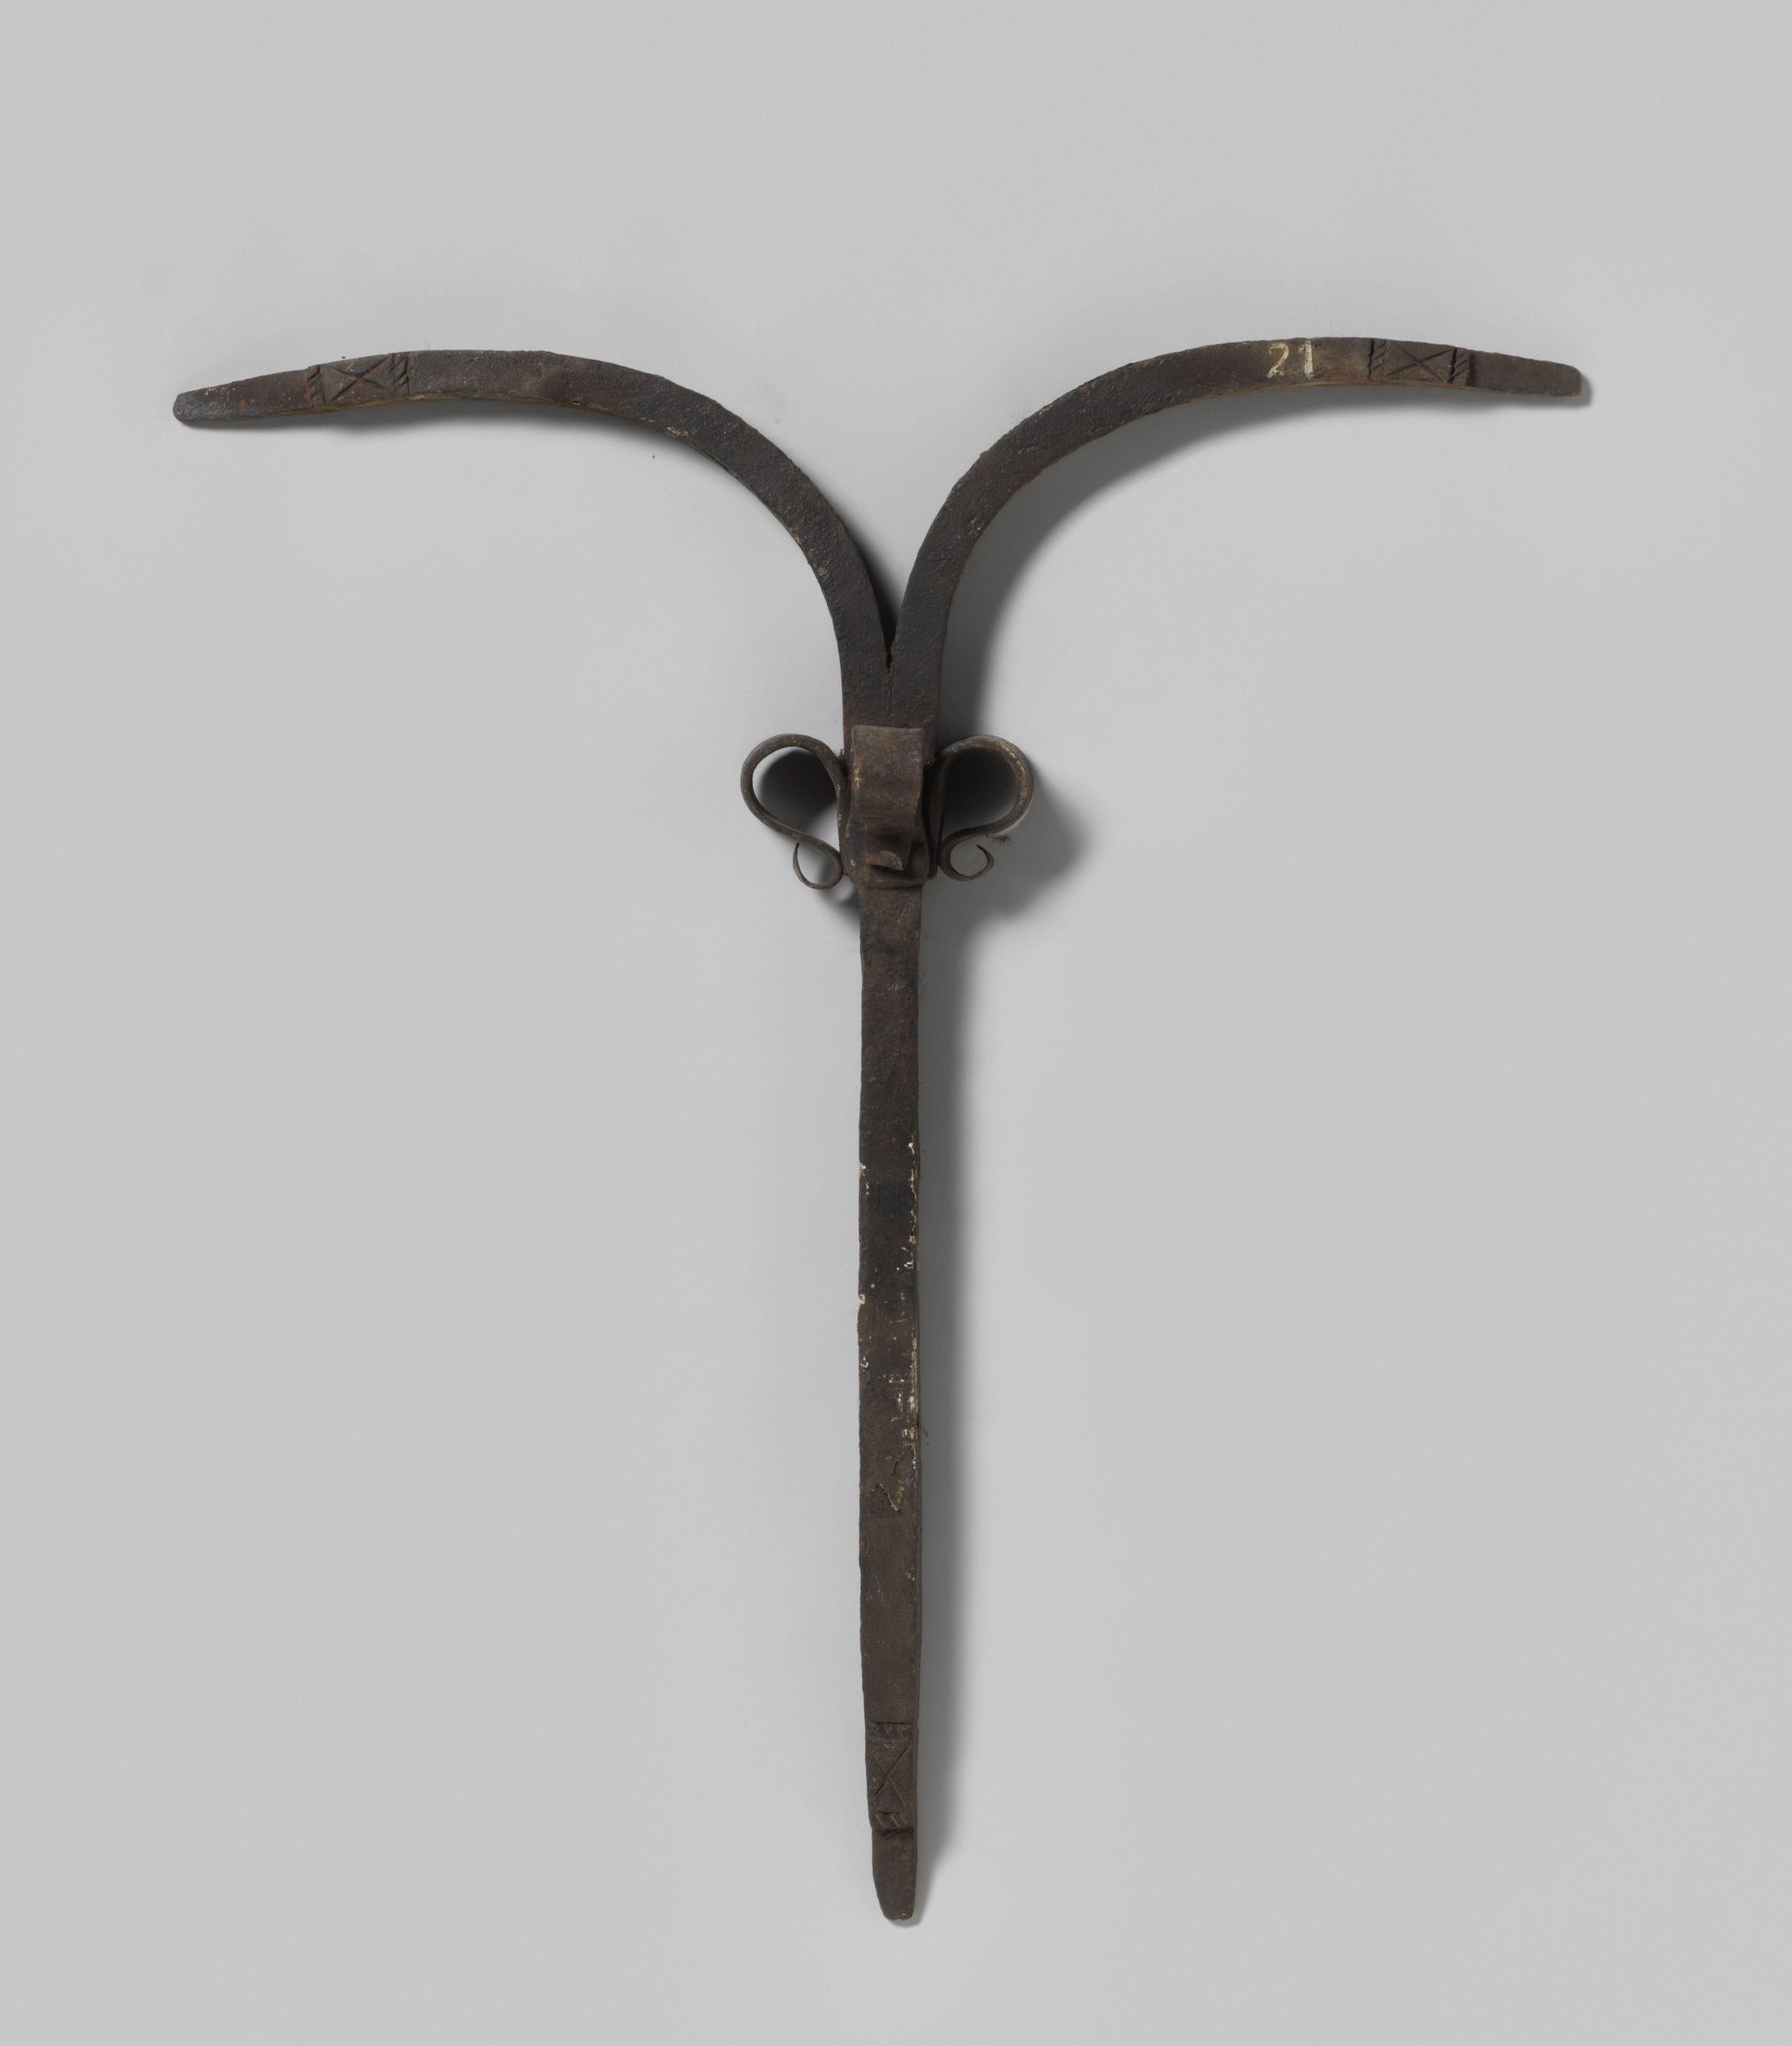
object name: schieter, schoter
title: Schieter van een muuranker van een huis te Arnhem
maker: Anonymous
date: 1400-1950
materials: iron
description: Schieter van een muuranker, uitgevoerd in gotische stijl. Afkomstig van een huis op de hoek van de Rijnstraat en de Weverstraat te Arnhem.